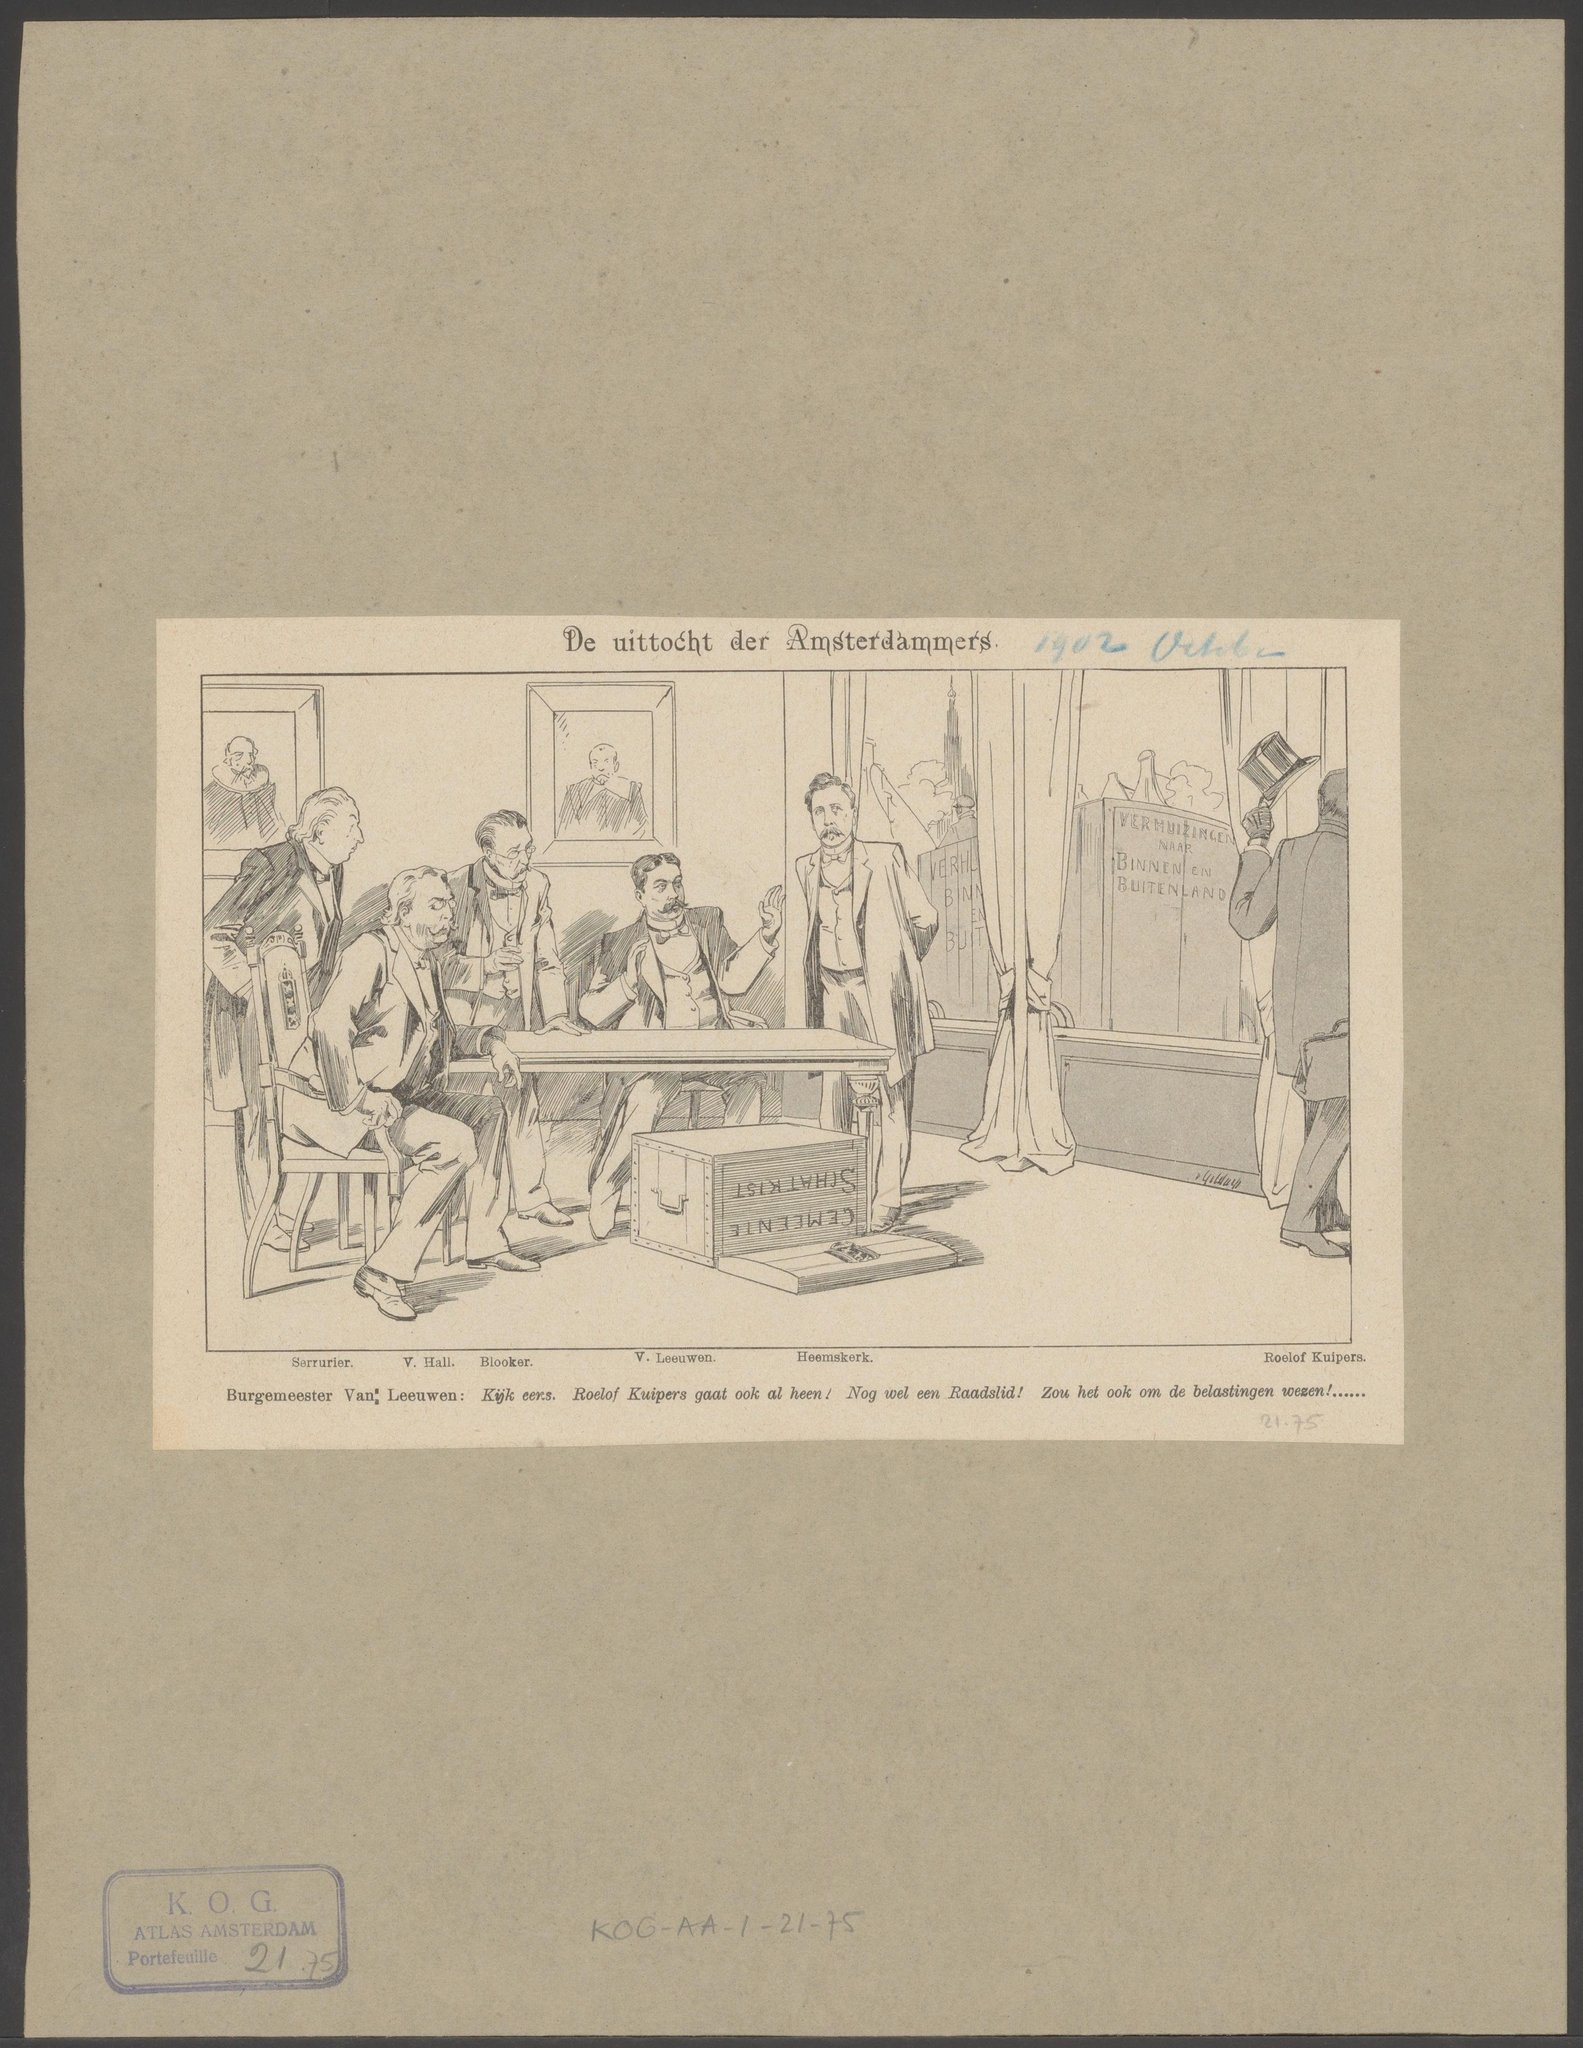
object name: newspaper clipping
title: Amsterdamse gemeenteraad en raadslid Roelof Kuipers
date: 1902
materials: paper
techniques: letterpress printing, line block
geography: amsterdam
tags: amsterdam, utrecht, politician, jacob nicolaas van hall, surabaya, the hague, mayor, politician, e.g. party leader, political caricatures and satires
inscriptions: collector's mark: Lugt 1641b, inscription: ‘October 1902’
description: Prent komt uit een onbekende publicatie, waarschijnlijk uit oktober 1902. Een vergelijkbare prent werd later gepubliceerd in: Geïllustreerd zondagsblad voor katholieken, november 1902.